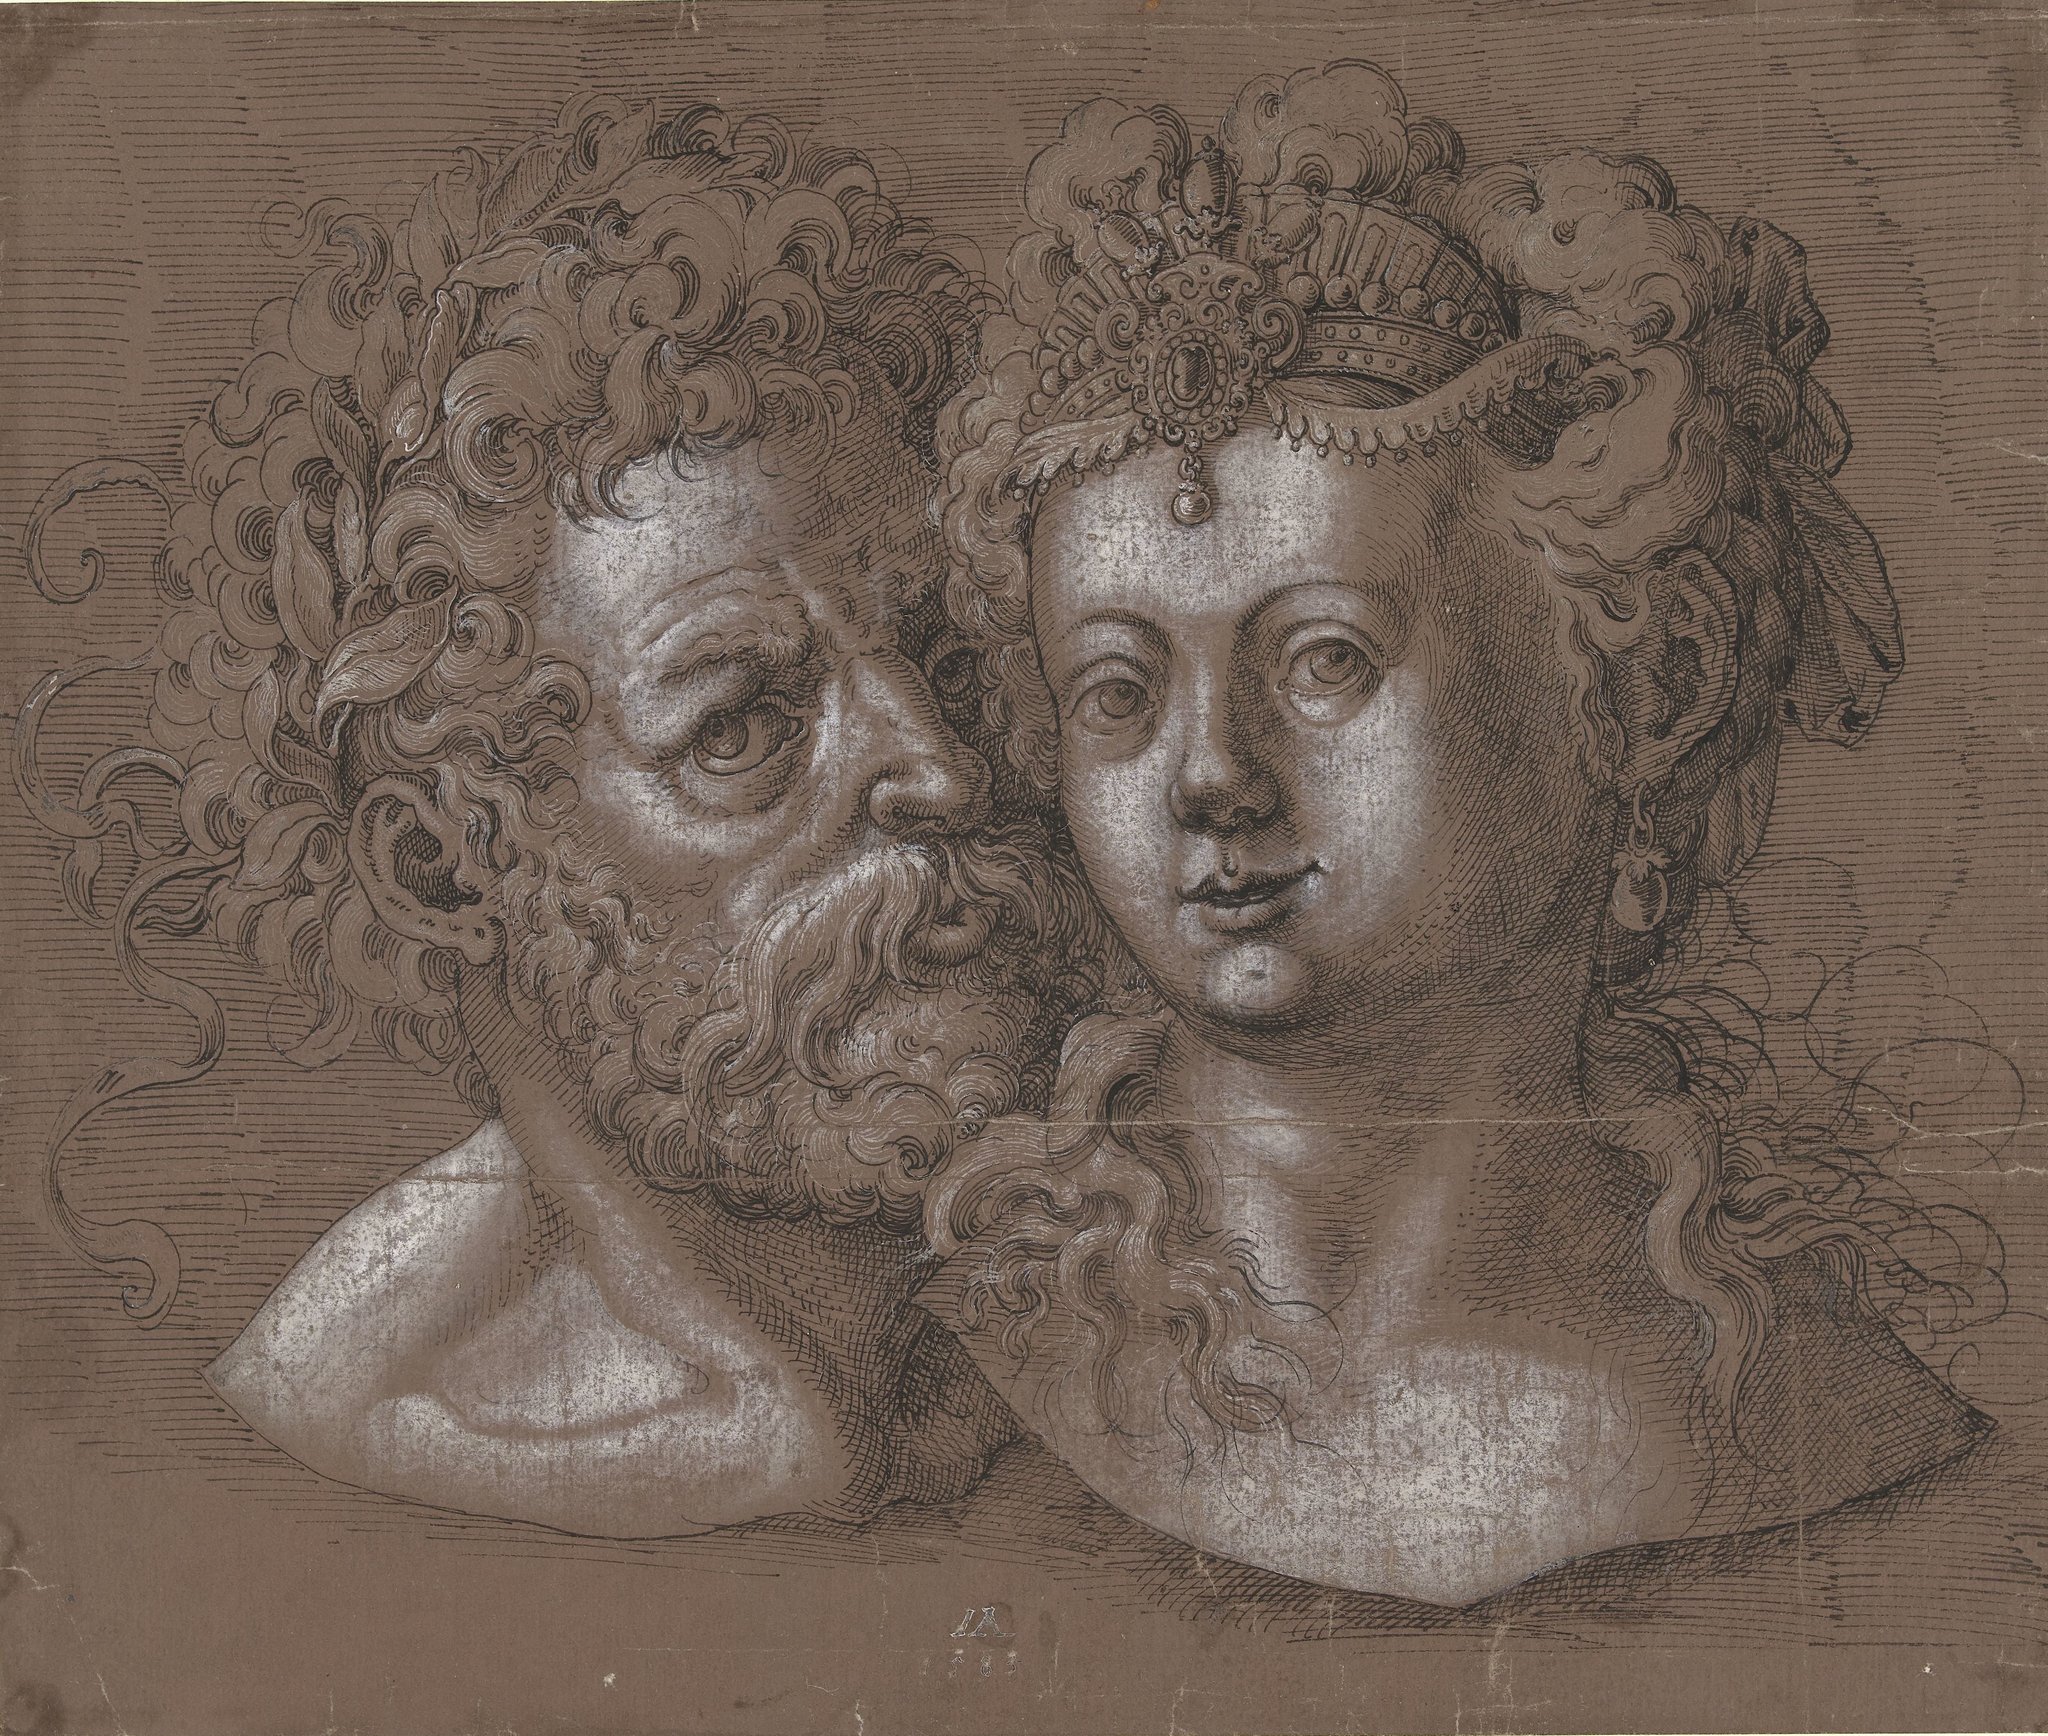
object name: drawing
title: Mans- en een vrouwenhoofd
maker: jost amman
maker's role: draughtsman, painter, print maker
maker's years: 1539-1591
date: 1585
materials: ink, paper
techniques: pen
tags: head (human), head (human) - aa - female human figure